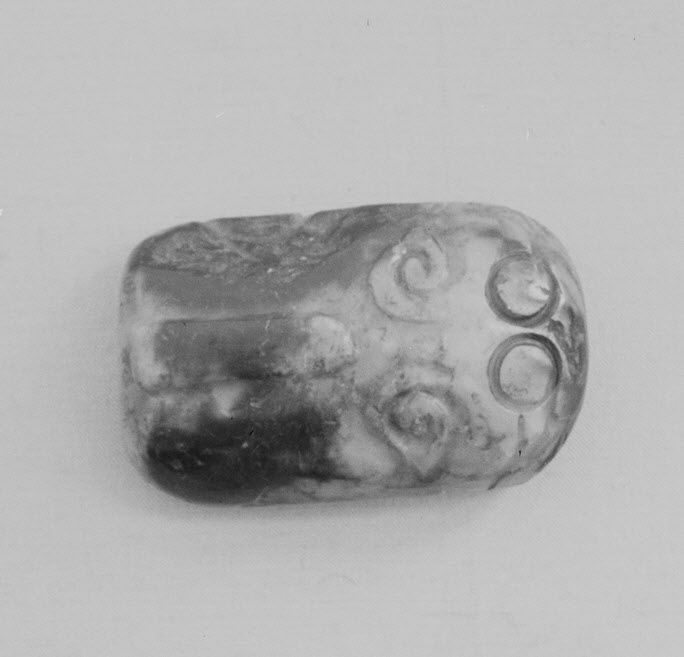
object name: weight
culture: chinese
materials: jade